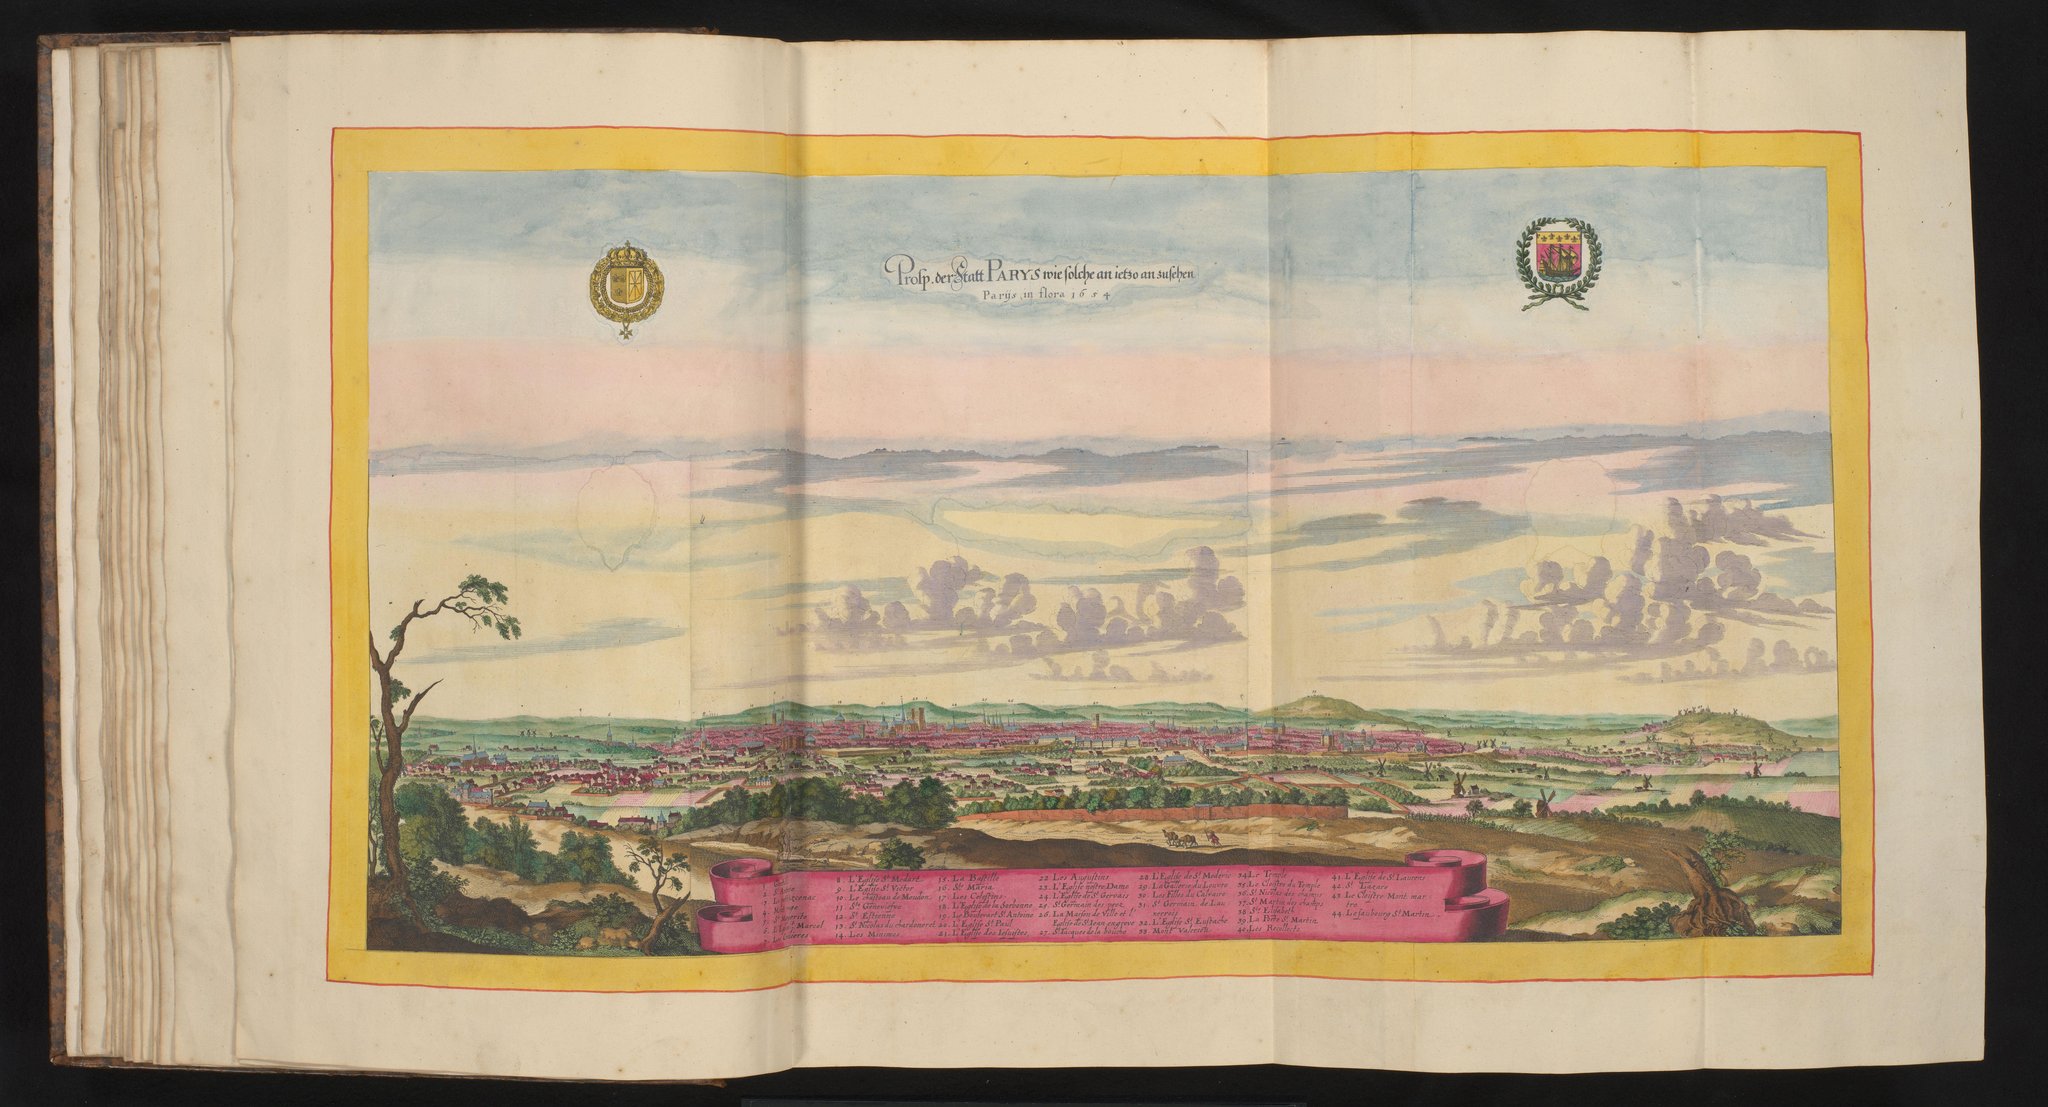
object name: album leaf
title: Gezicht op de stad Parijs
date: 1655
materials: paper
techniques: engraving, etching, hand coloring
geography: paris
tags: prospect of city, town panorama, silhouette of city, paris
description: Prent origineel vervaardigd als boekillustratie voor: Zeiller, Martin. Topographia Galliae, oder Beschreibung und Contrafaitung der vornehmbsten und bekantisten Oerter in dem mächtigen und grossen Königreich Frankreich, 13 delen. Frankfurt am Main: Caspar Merian, 1655-1661. De prent werd voor het eerst gepubliceerd in deel 1: Topographia Galliae, 1655.